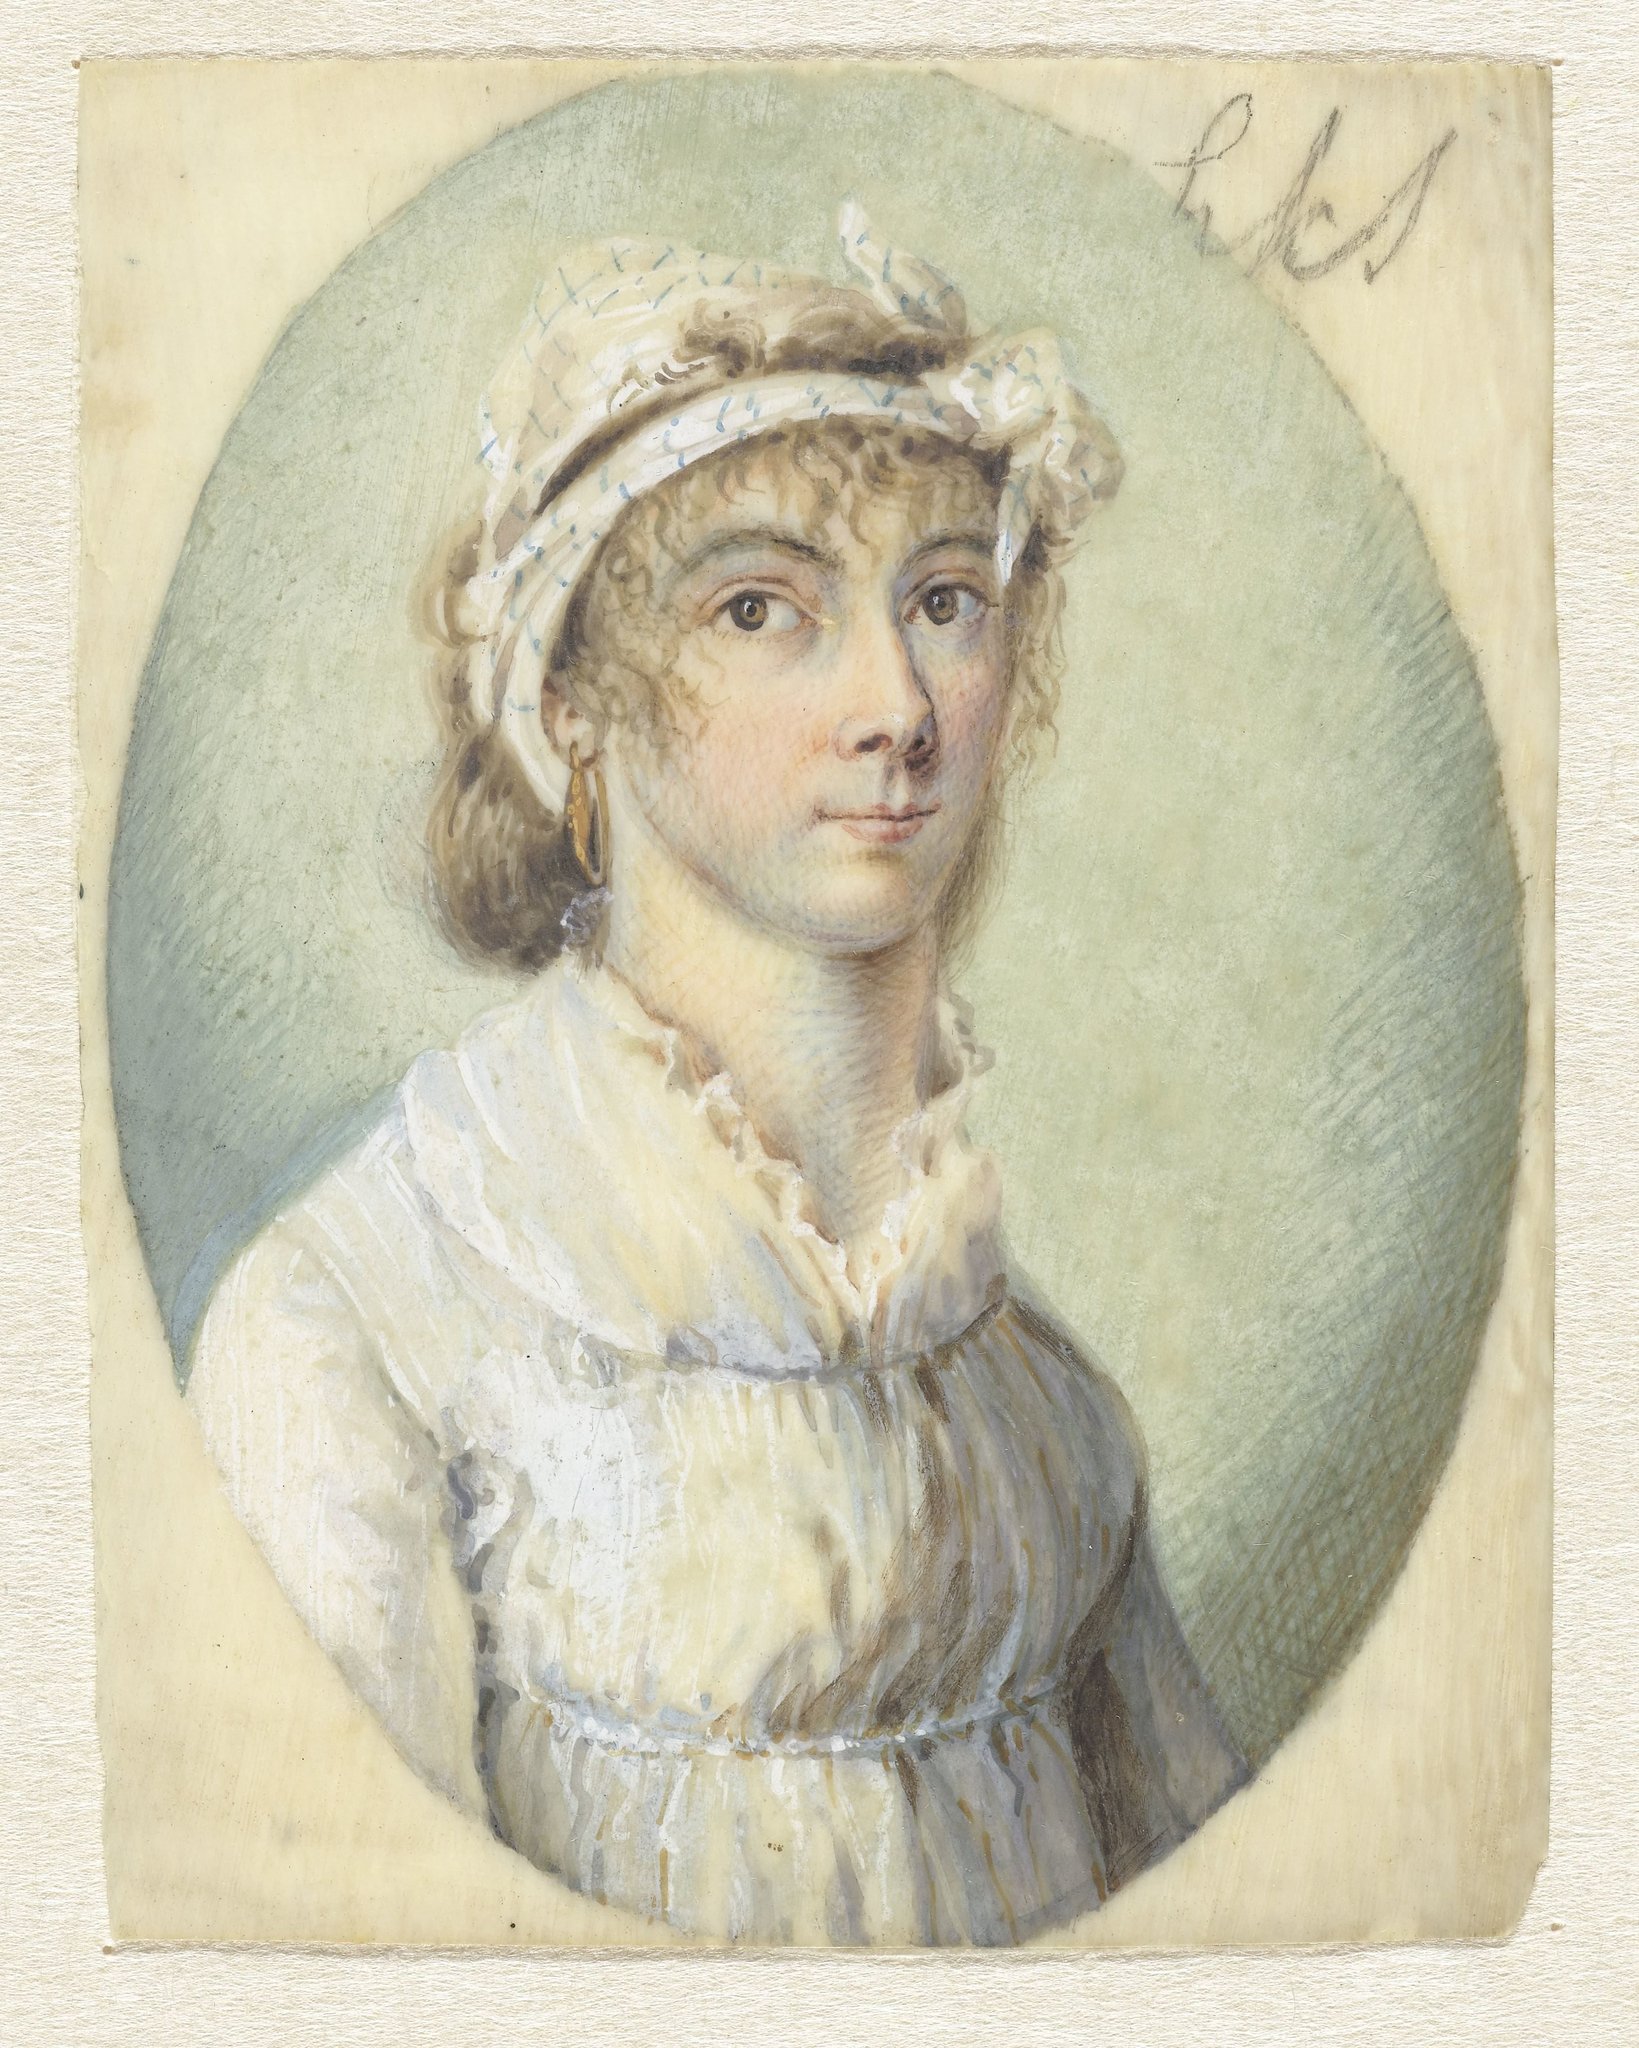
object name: drawing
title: Portret van een jonge vrouw, driekwart naar rechts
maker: pieter gerardus van os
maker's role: draughtsman, painter, print maker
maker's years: 1776-1839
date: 1786-1839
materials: paint, gouache, ivory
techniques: brush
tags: anonymous historical person portrayed alone